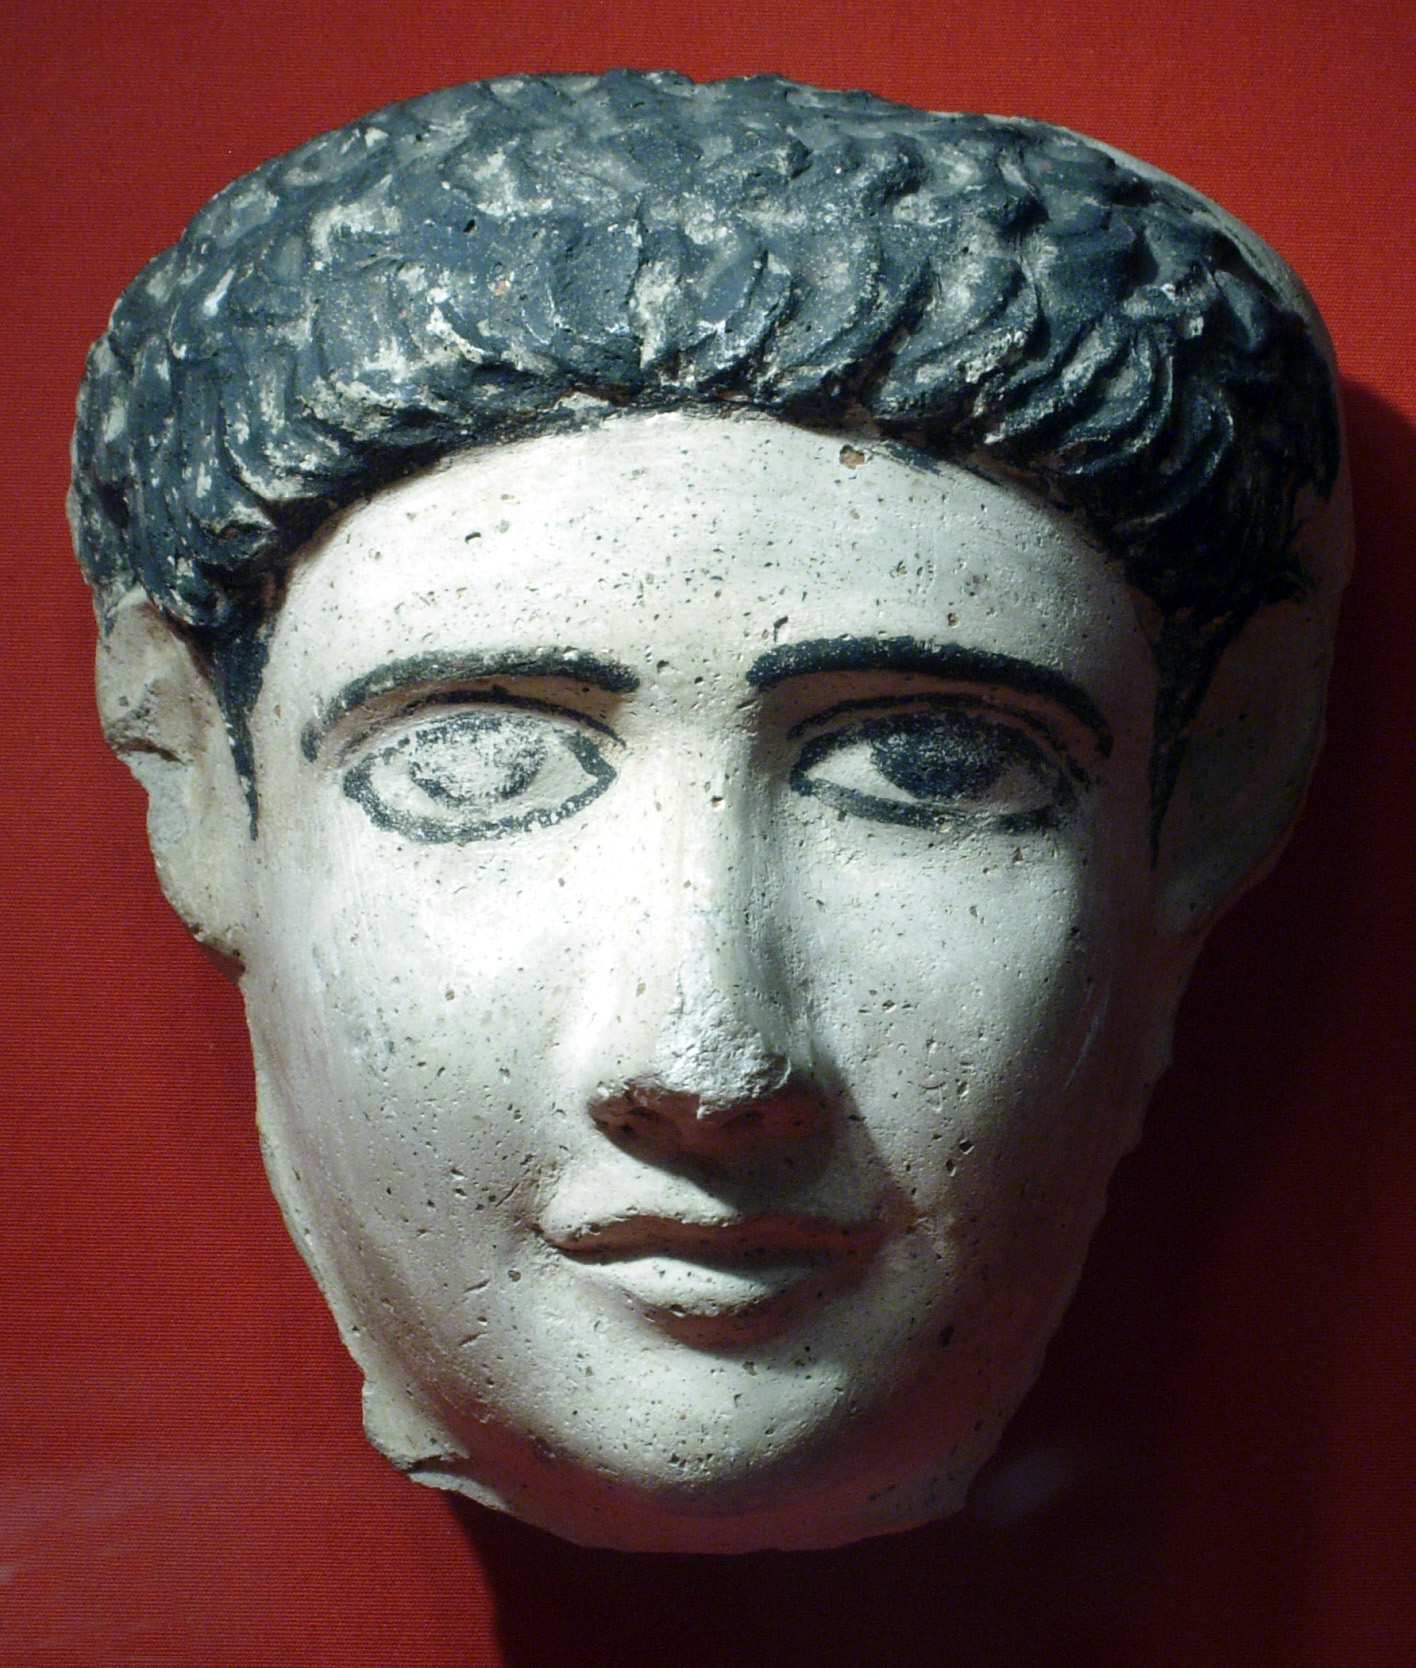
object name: mask, boy, with short lock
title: Small mask, possibly of a boy, with short locks combed to the front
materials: paint, plaster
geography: egypt